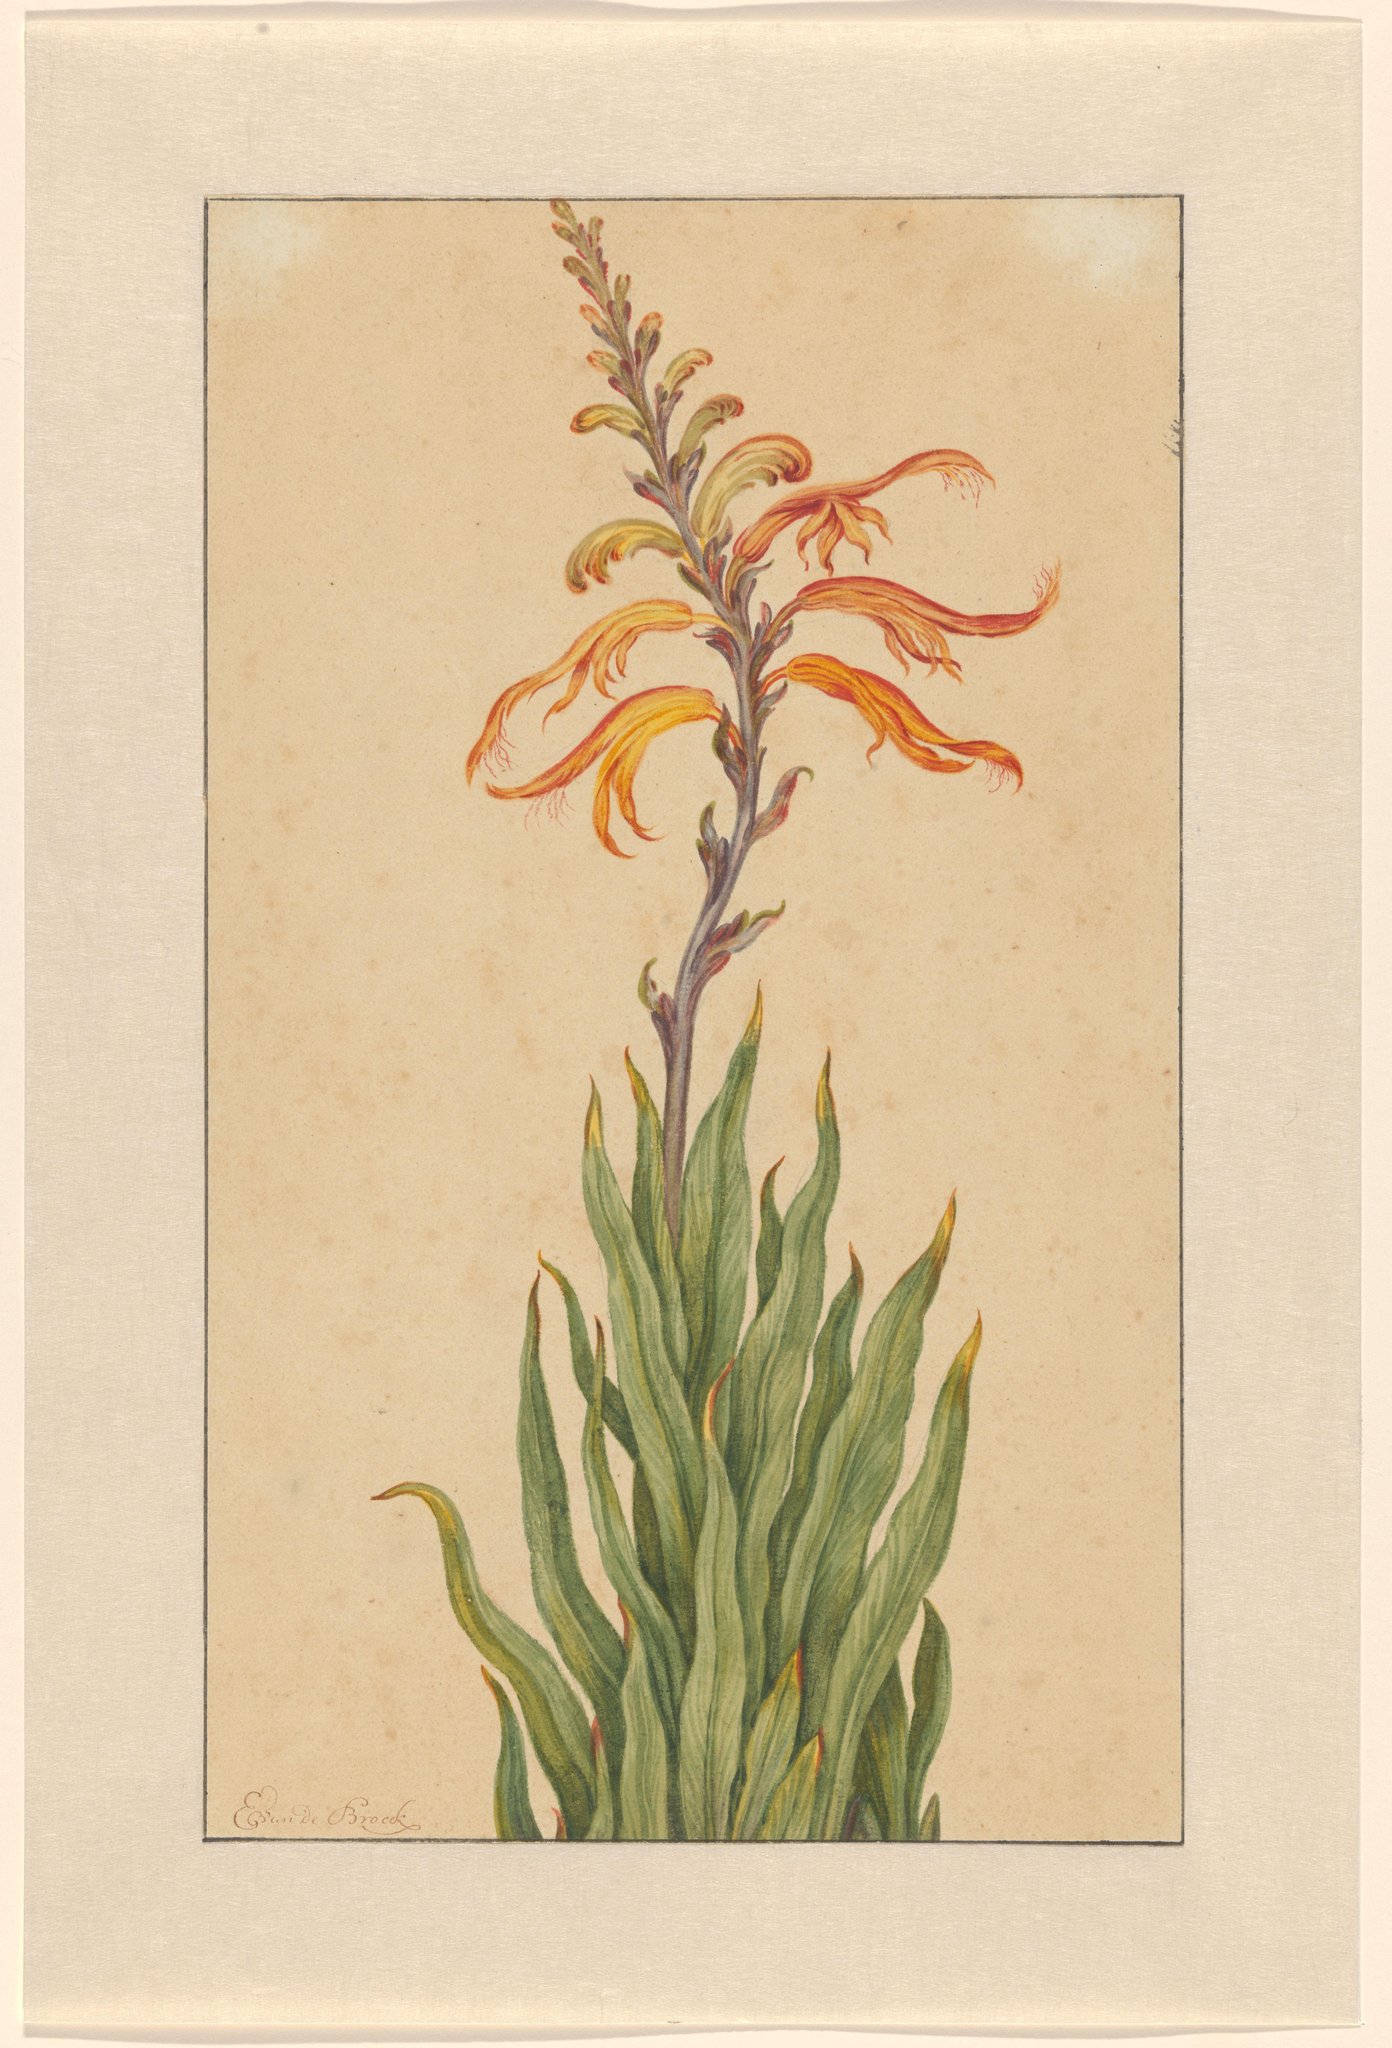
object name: drawing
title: Crocosmia (Montbretia)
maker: elias van den broeck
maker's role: painter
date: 1650-1708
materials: paper, watercolor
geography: amsterdam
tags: flowers: crocosmia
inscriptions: signature: ‘Elias V. De Broeck’